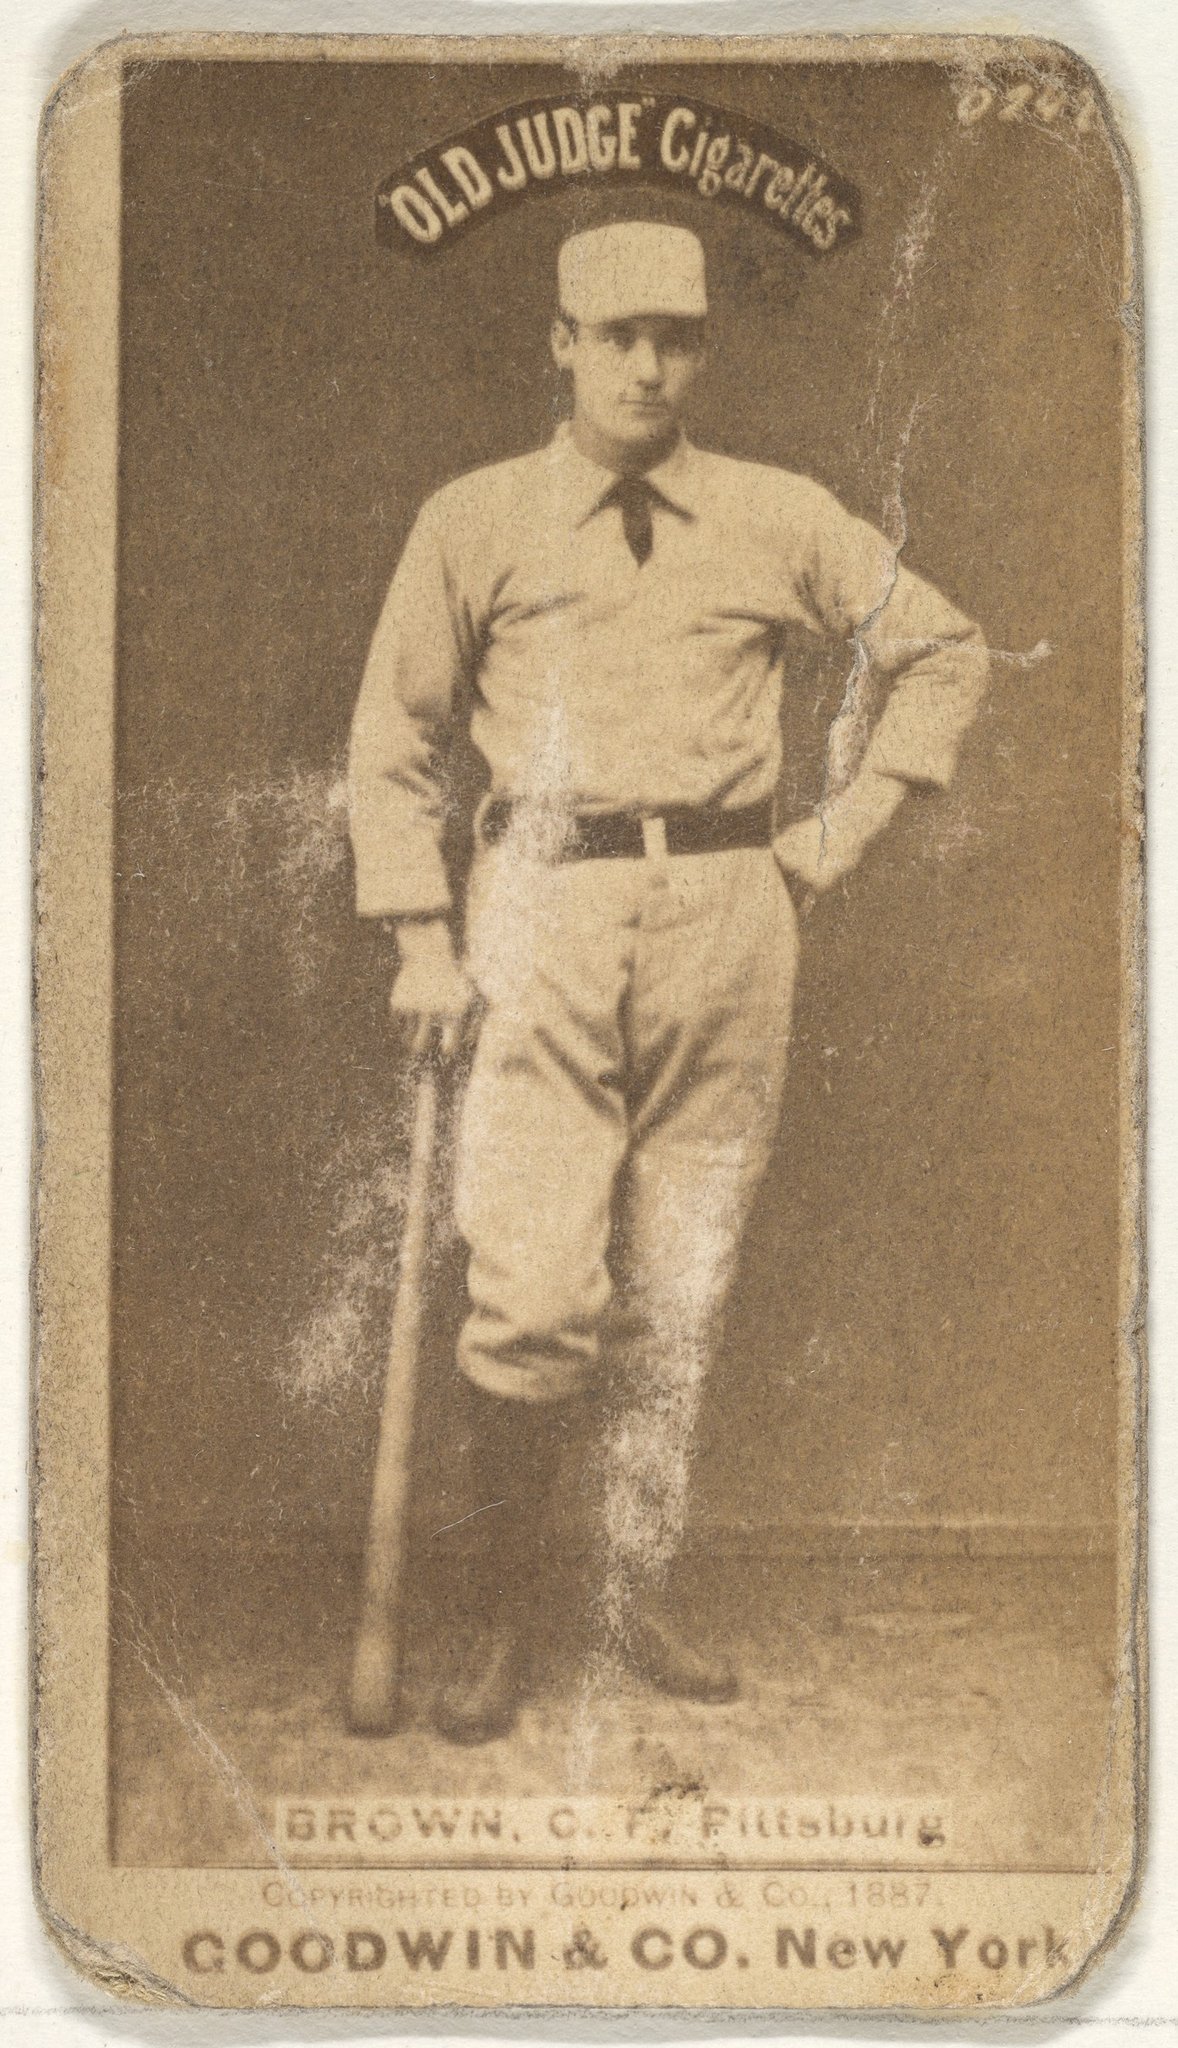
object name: baseball card, photograph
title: Thomas "Tom" Tarlton Brown, Center Field, Pittsburgh, from the Old Judge series (N172) for Old Judge Cigarettes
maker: goodwin & company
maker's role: publisher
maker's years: 1850-1950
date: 1887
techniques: albumen silver print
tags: men,portraits,baseball,athletes